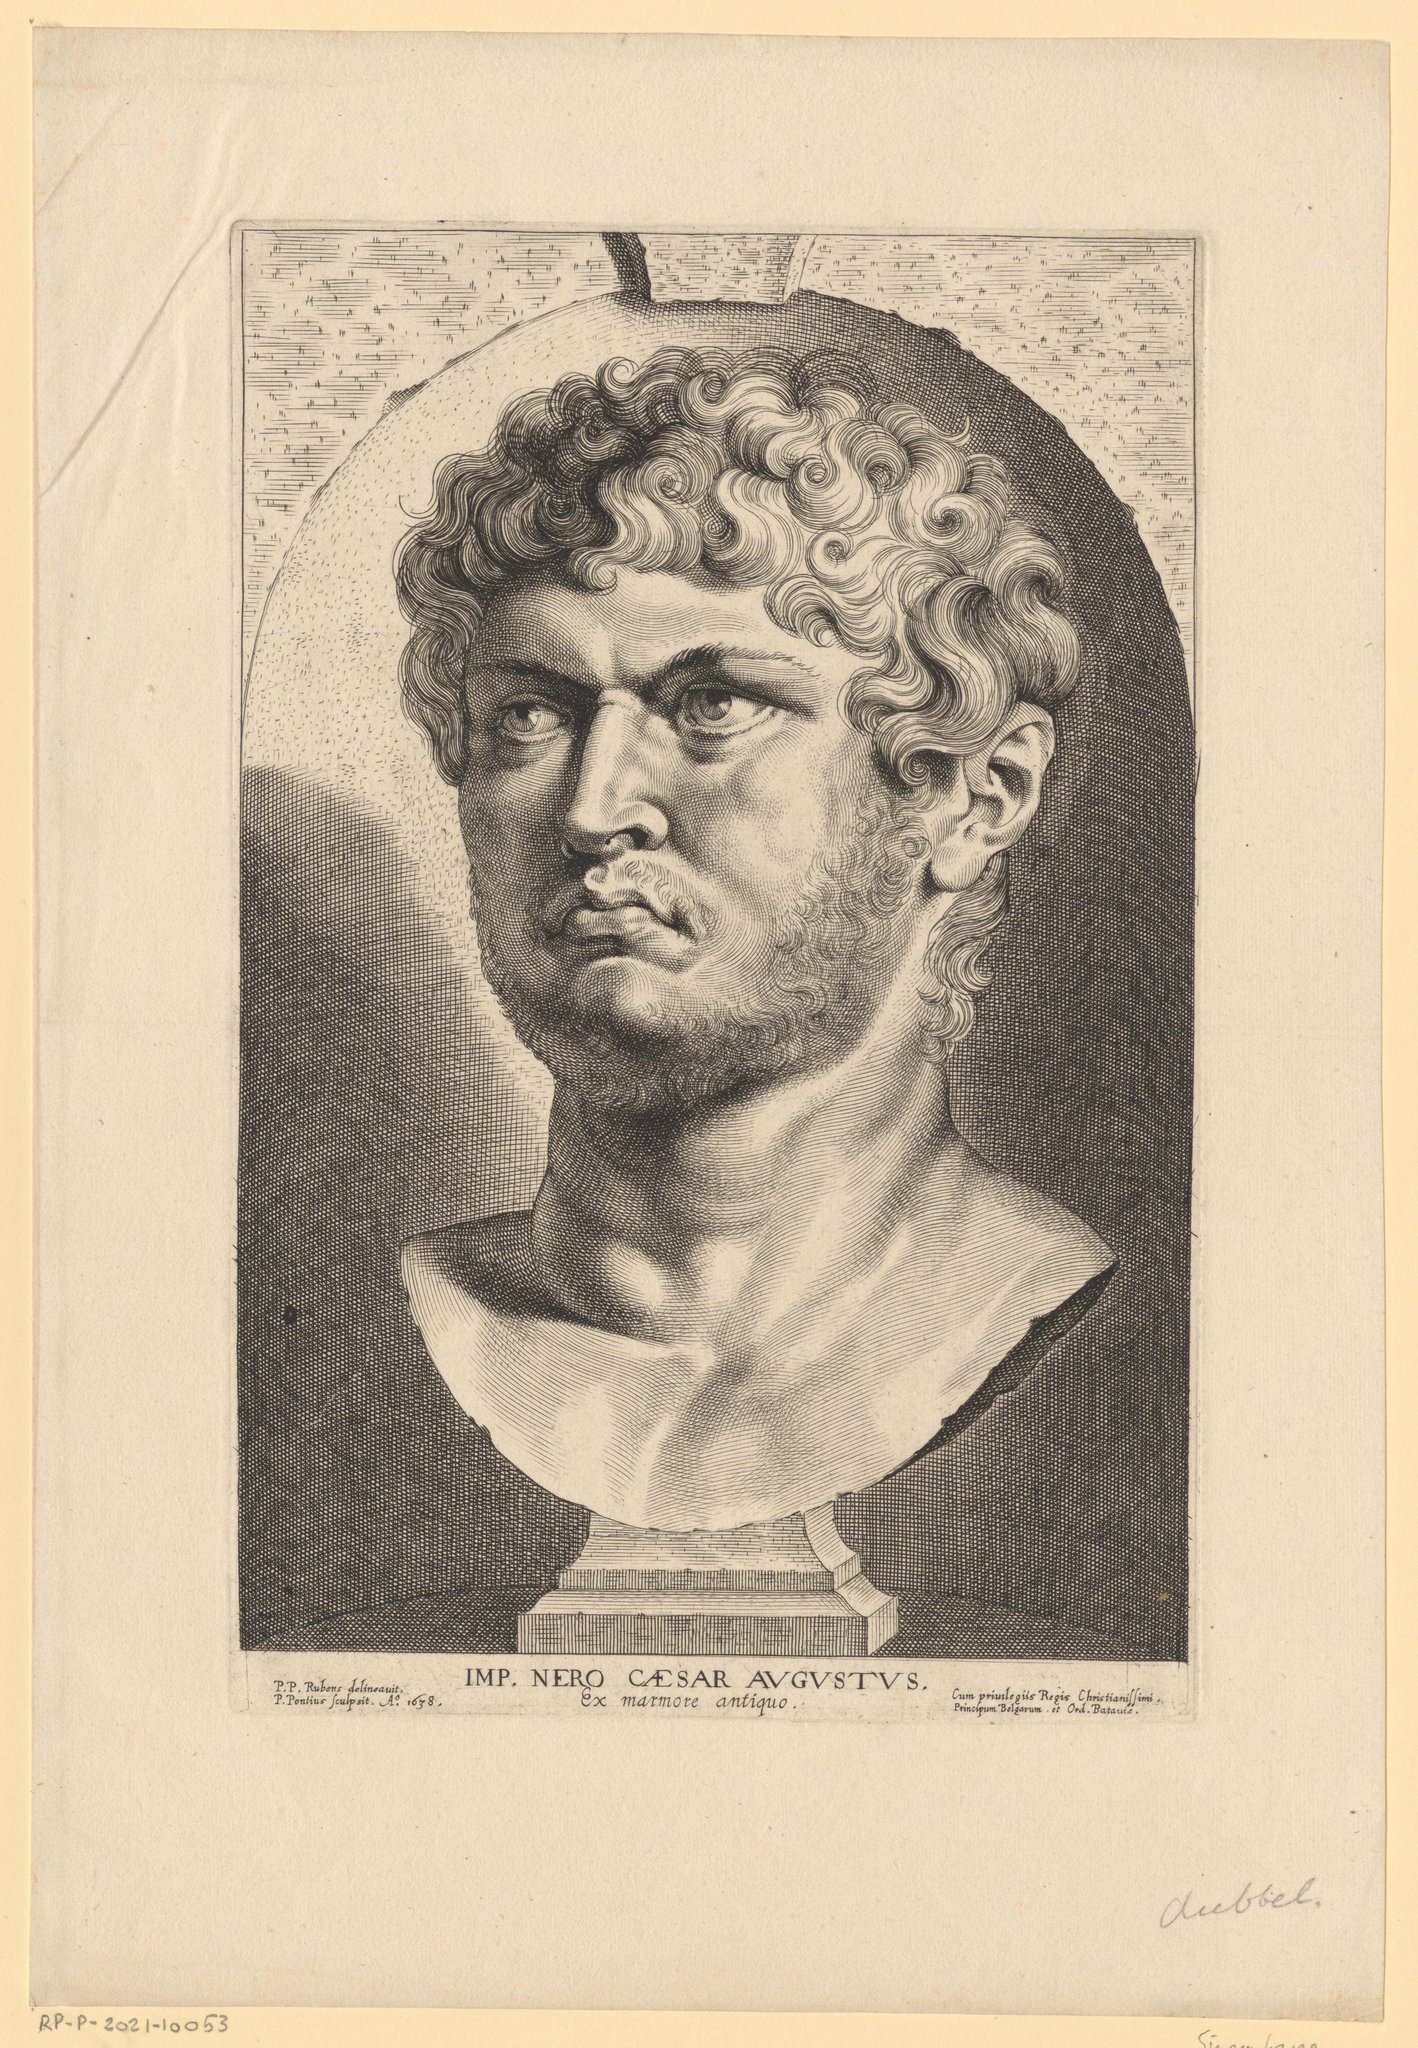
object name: print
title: Portret van Nero, keizer van het Romeinse Rijk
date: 1638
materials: paper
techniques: engraving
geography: antwerp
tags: historical persons, emperor, piece of sculpture, reproduction of a piece of sculpture